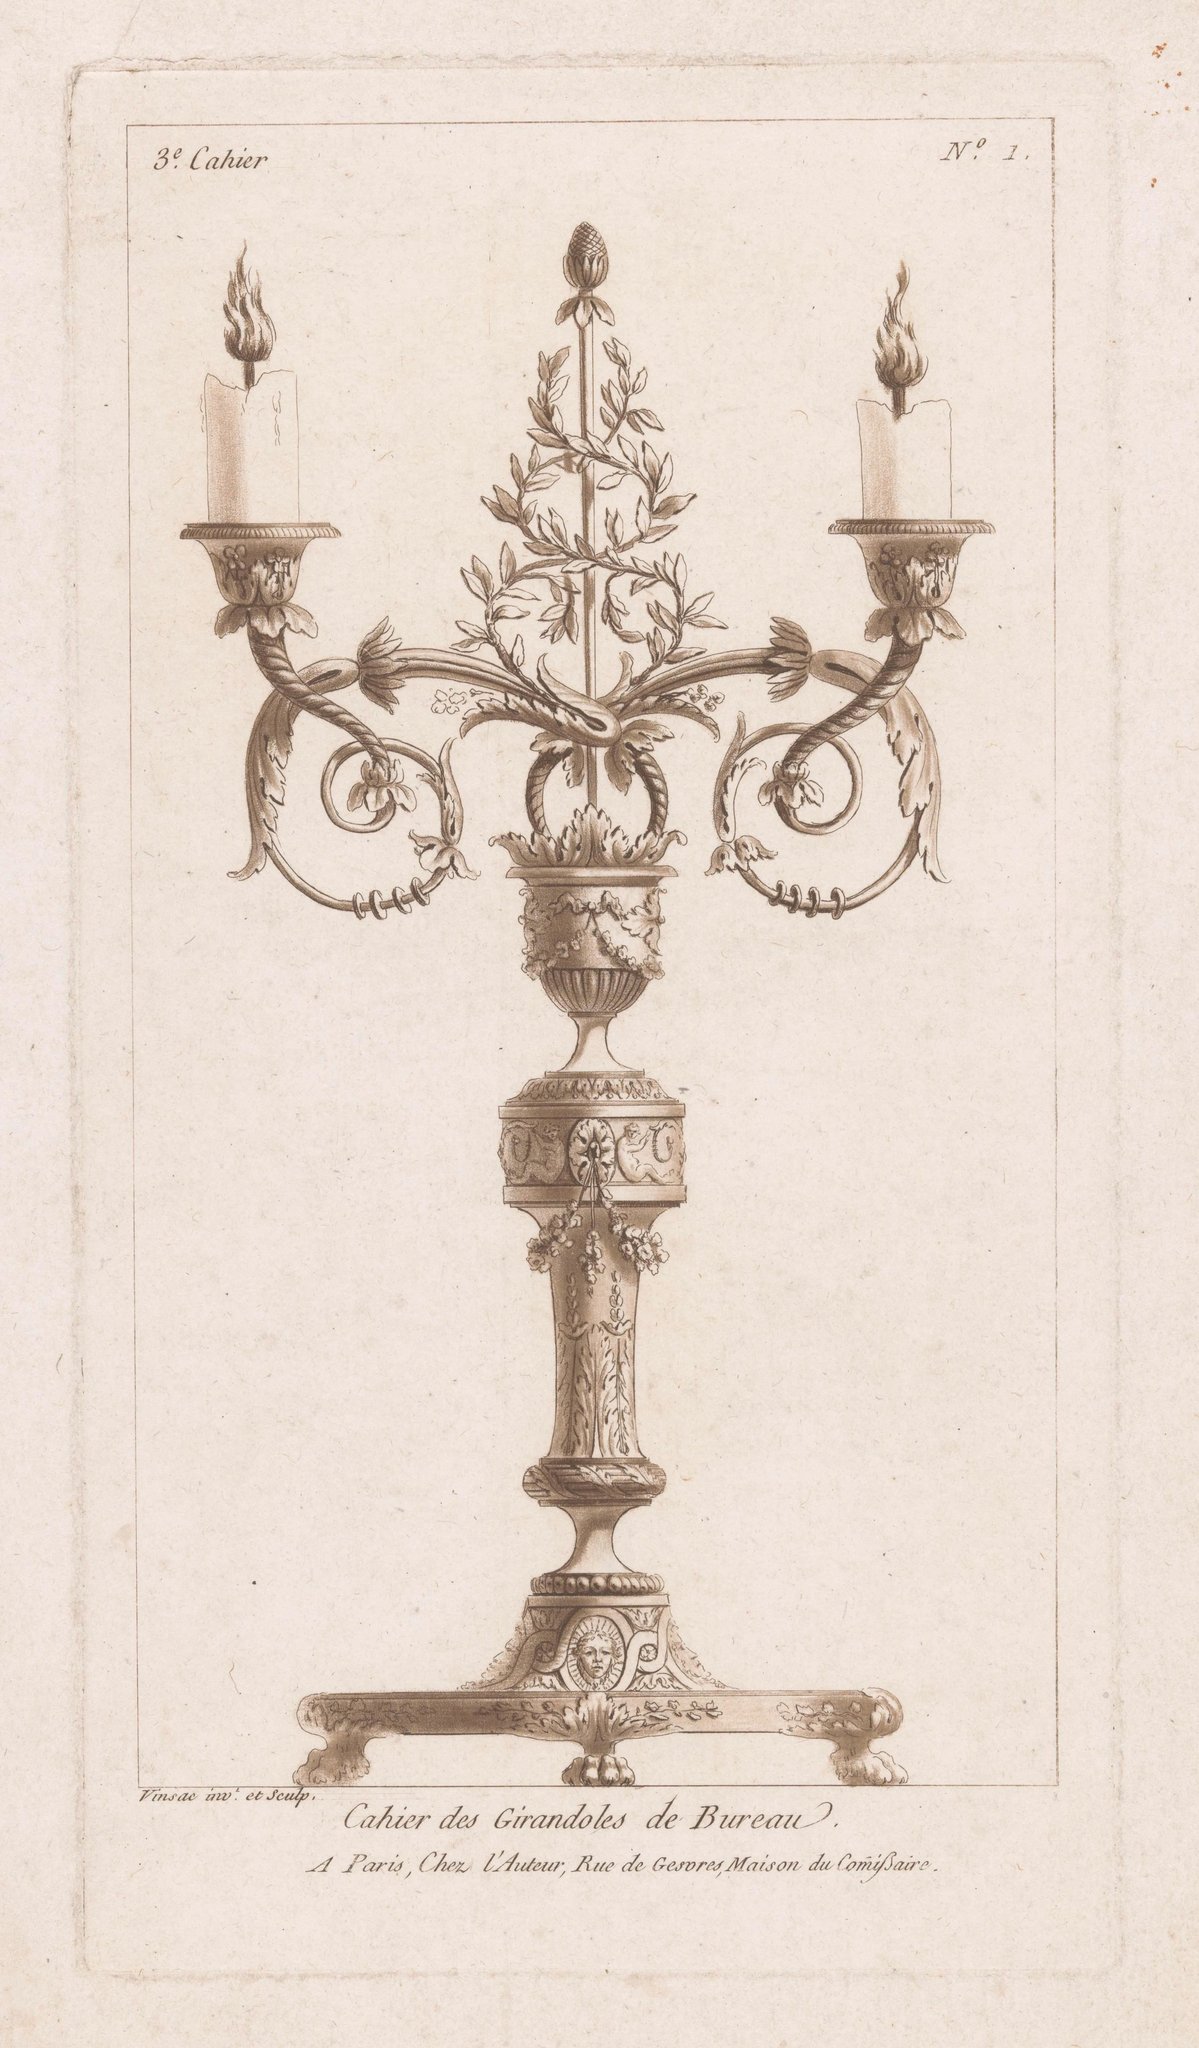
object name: titelprent, frontispice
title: Girandole met thyrsus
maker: claude dominique vinsac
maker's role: print maker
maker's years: 1749-1800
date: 1759-1800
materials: paper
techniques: aquatint, etching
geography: paris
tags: thyrsus ~ attribute of bacchus, chandelier, candelabrum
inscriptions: collector's mark: Lugt 2228, collector's mark: Lugt 2760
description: Een tweearmige girandole met ranken, vlechtwerk en een thyrsus.